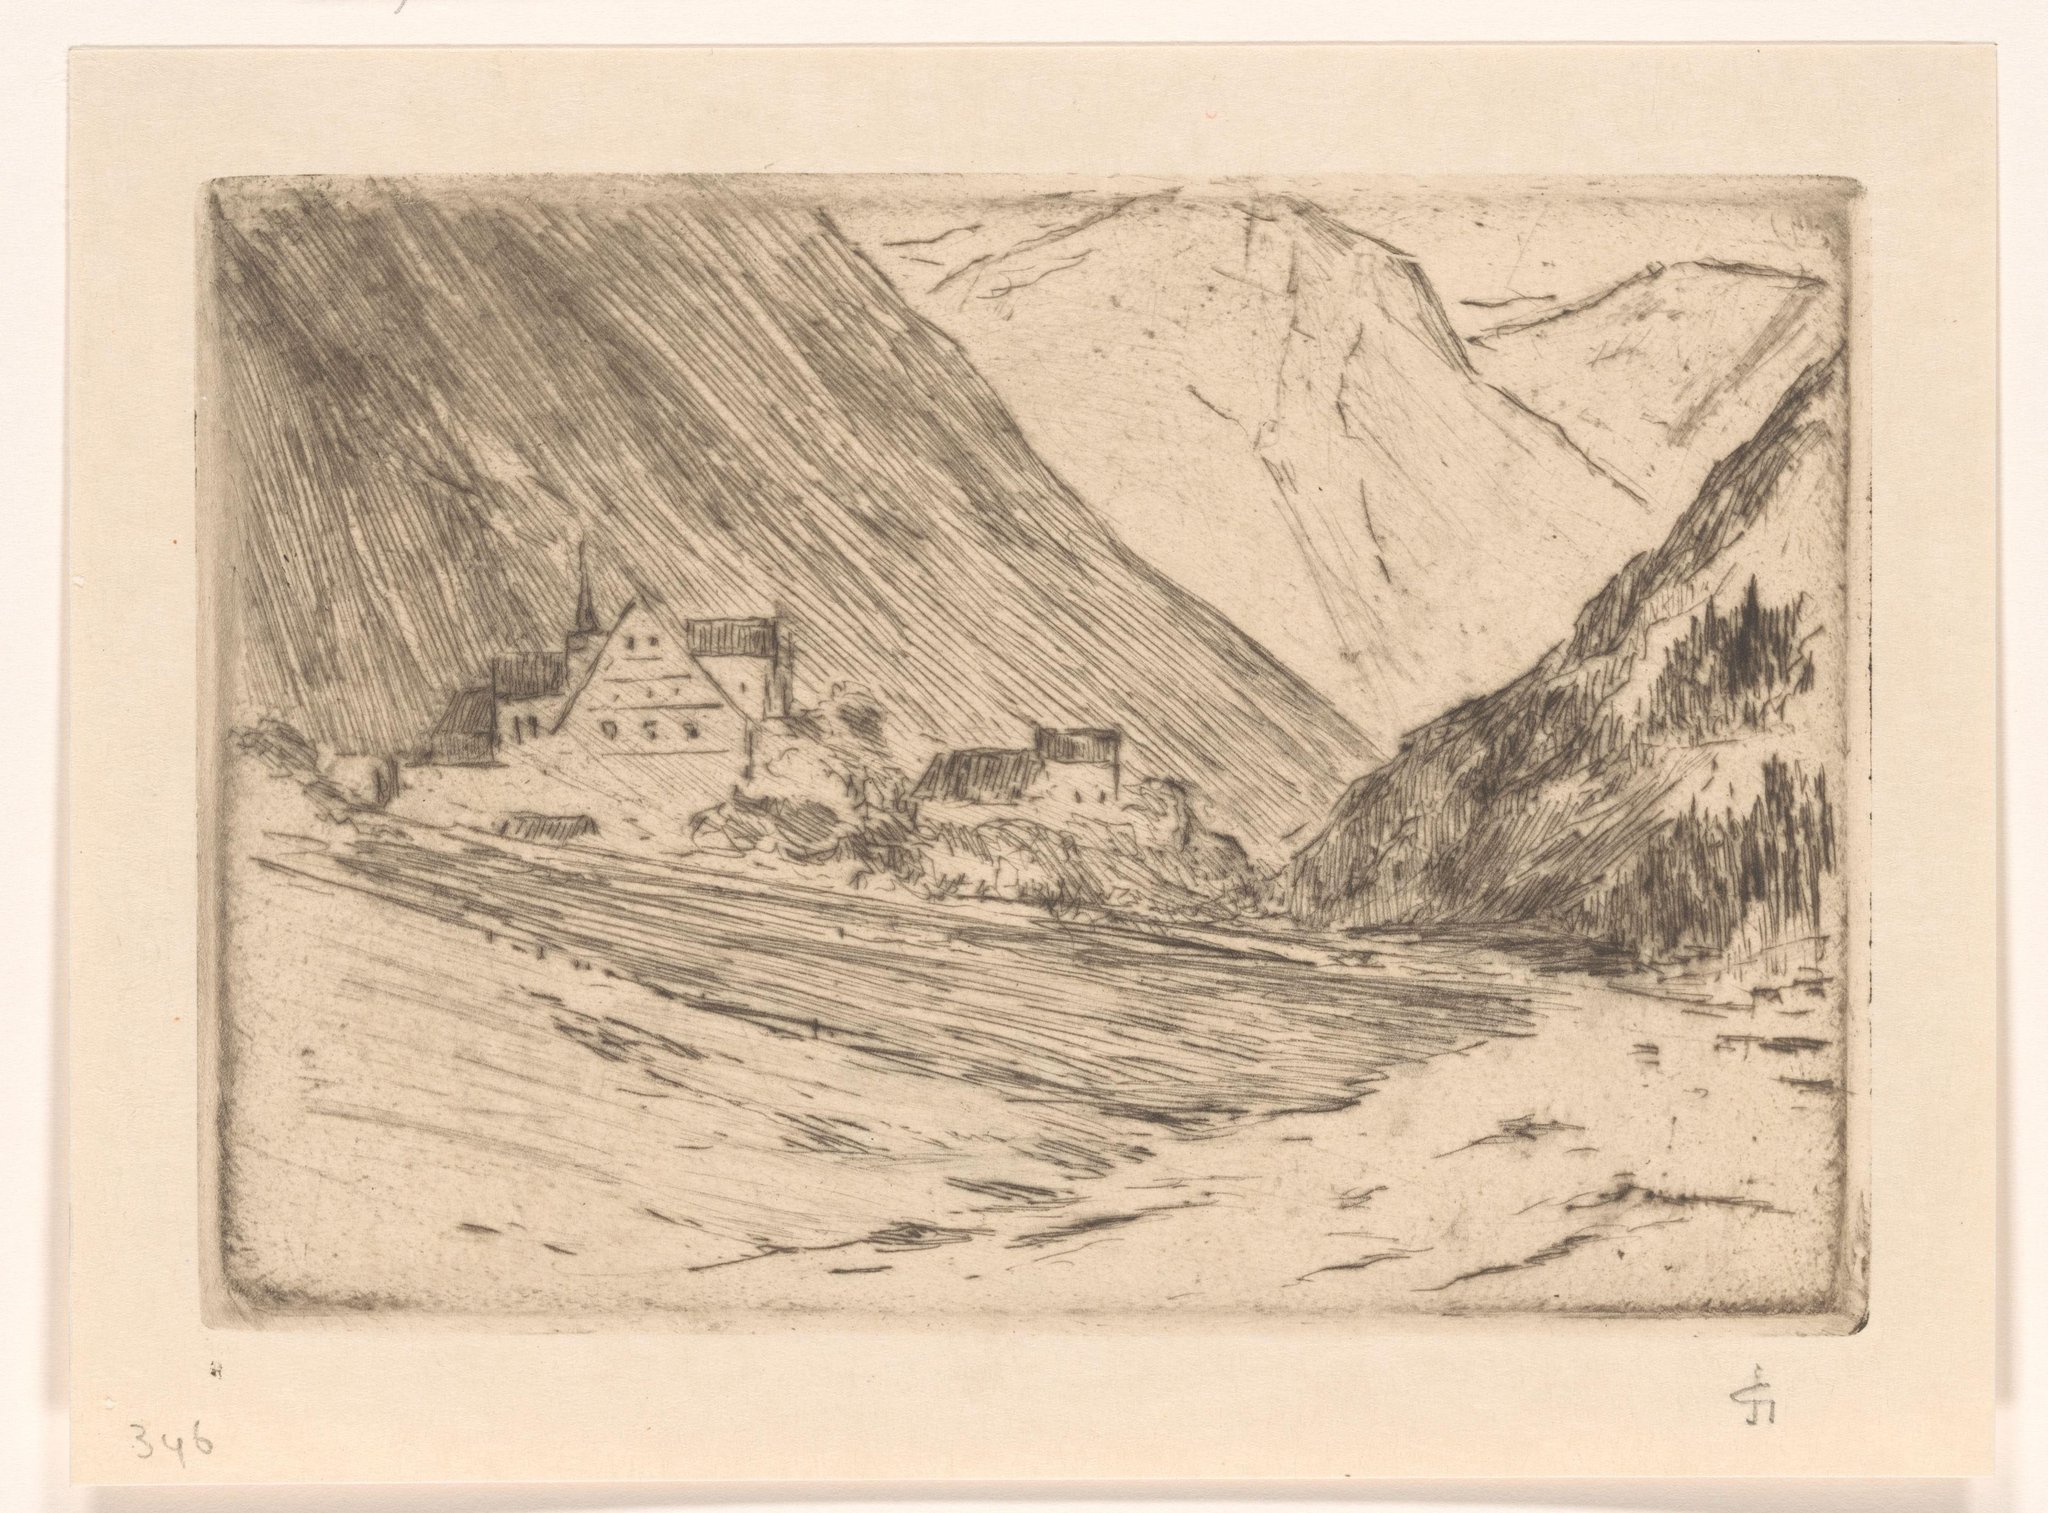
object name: print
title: Gezicht op het klooster van Sint-Josef in Muotathal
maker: carel nicolaas storm van s-gravesande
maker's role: draughtsman, print maker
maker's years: 1841-1924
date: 1889-1902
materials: paper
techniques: drypoint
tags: abbey, monastery, convent ~ roman catholic church, mountains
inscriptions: number: ‘346’, collector's mark: Lugt 2228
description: Mogelijk vermeld in: Storm van 's-Gravesande, Charles. Catalogue des eaux-fortes et lithographies. New York: s.n., 1903, of in een onbekende latere uitgave van het manuscript. Vermoedelijk vermeld als catalogusnummer 346.